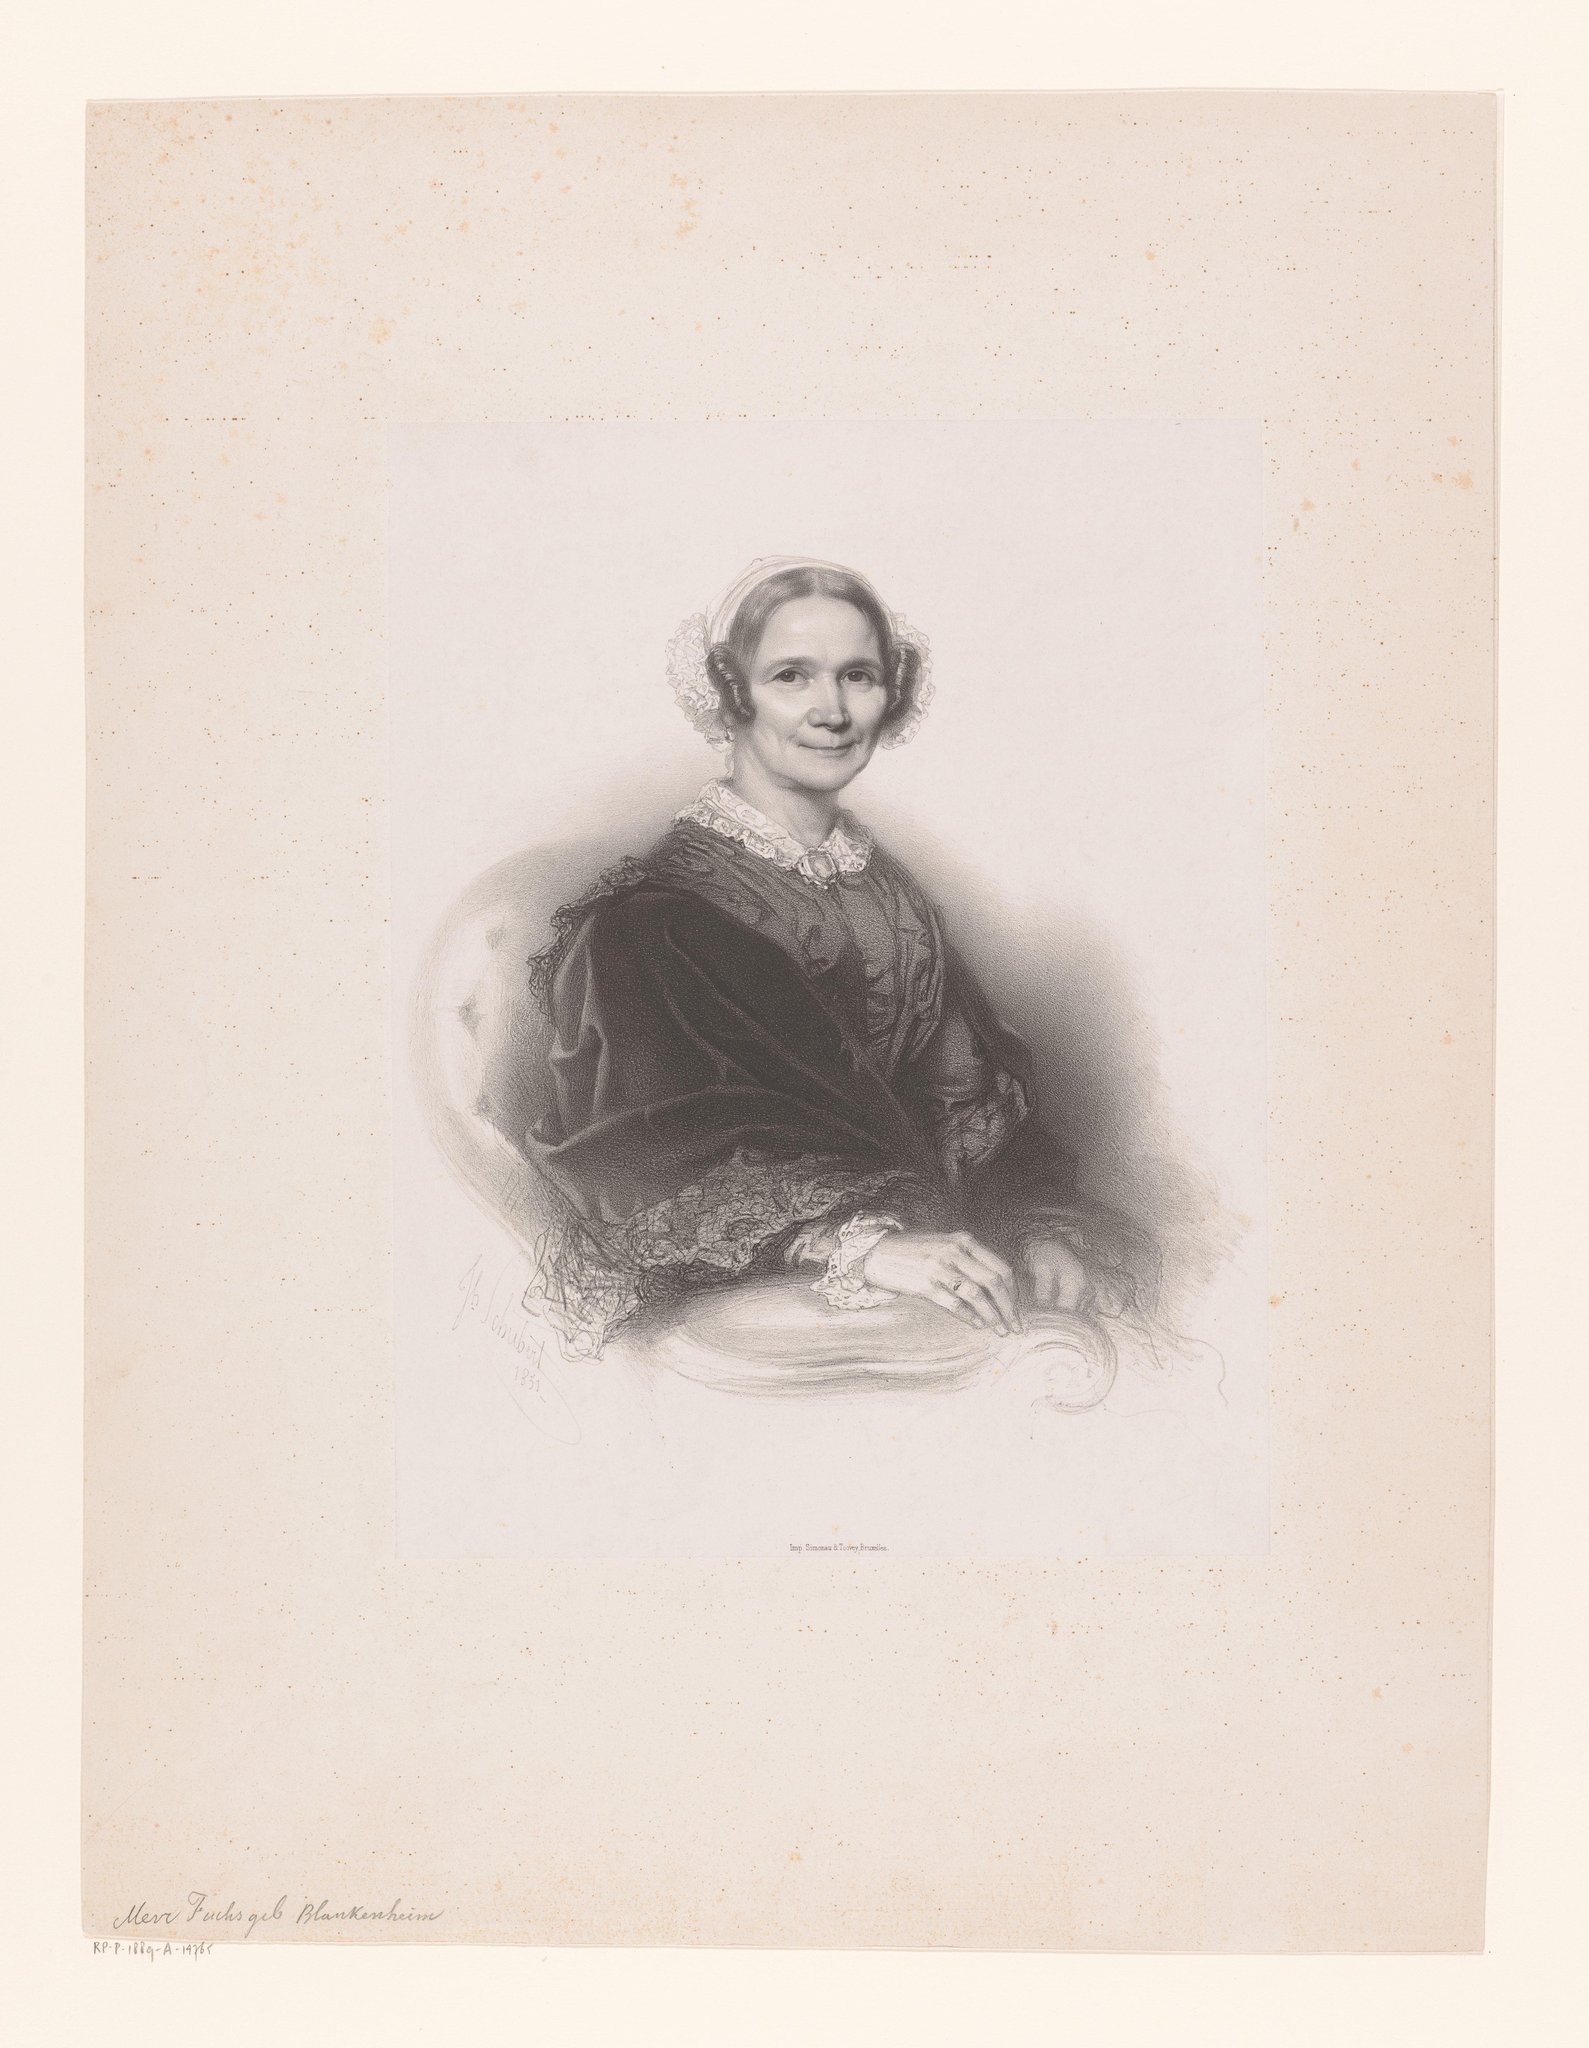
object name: print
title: Portret van een onbekende vrouw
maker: joseph schubert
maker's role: print maker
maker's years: 1816-1885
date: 1851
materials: paper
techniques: lithograph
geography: brussels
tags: armchair, seat, adult woman, historical persons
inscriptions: collector's mark: Lugt 2228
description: Volgens een later opschrift in potlood op object gaat het mogelijk om een portret van mevrouw Fuchs-Blankenheim of Nolet de Brauwere.